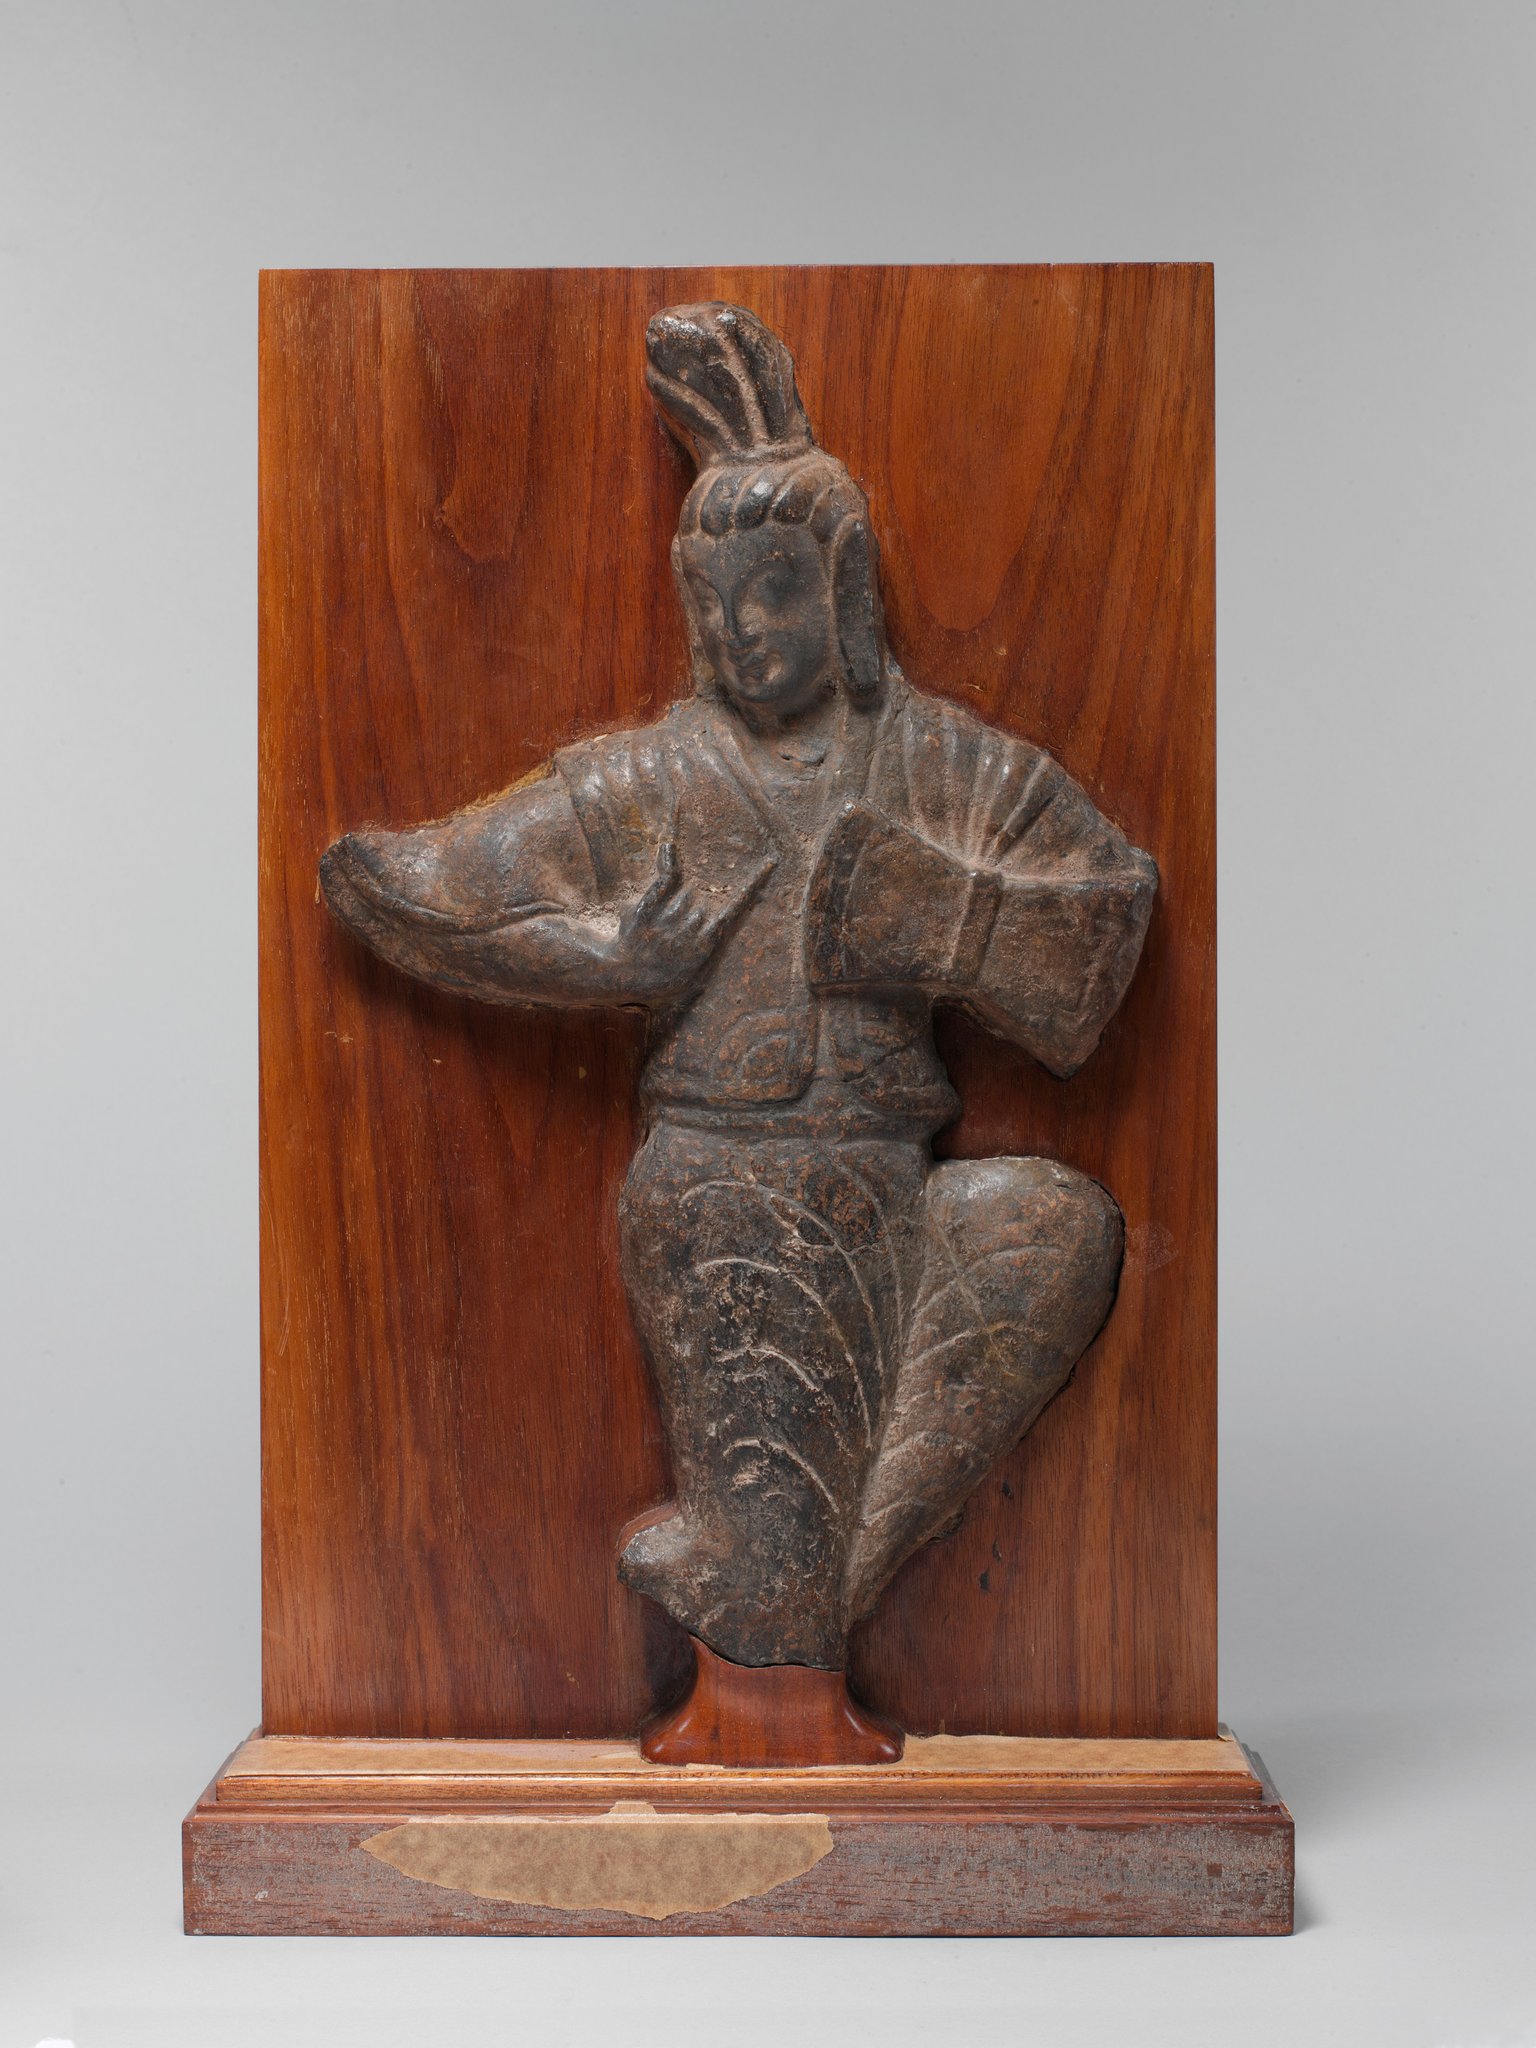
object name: relief figure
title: Musician playing a drum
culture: chinese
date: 501-533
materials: limestone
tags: men,drums